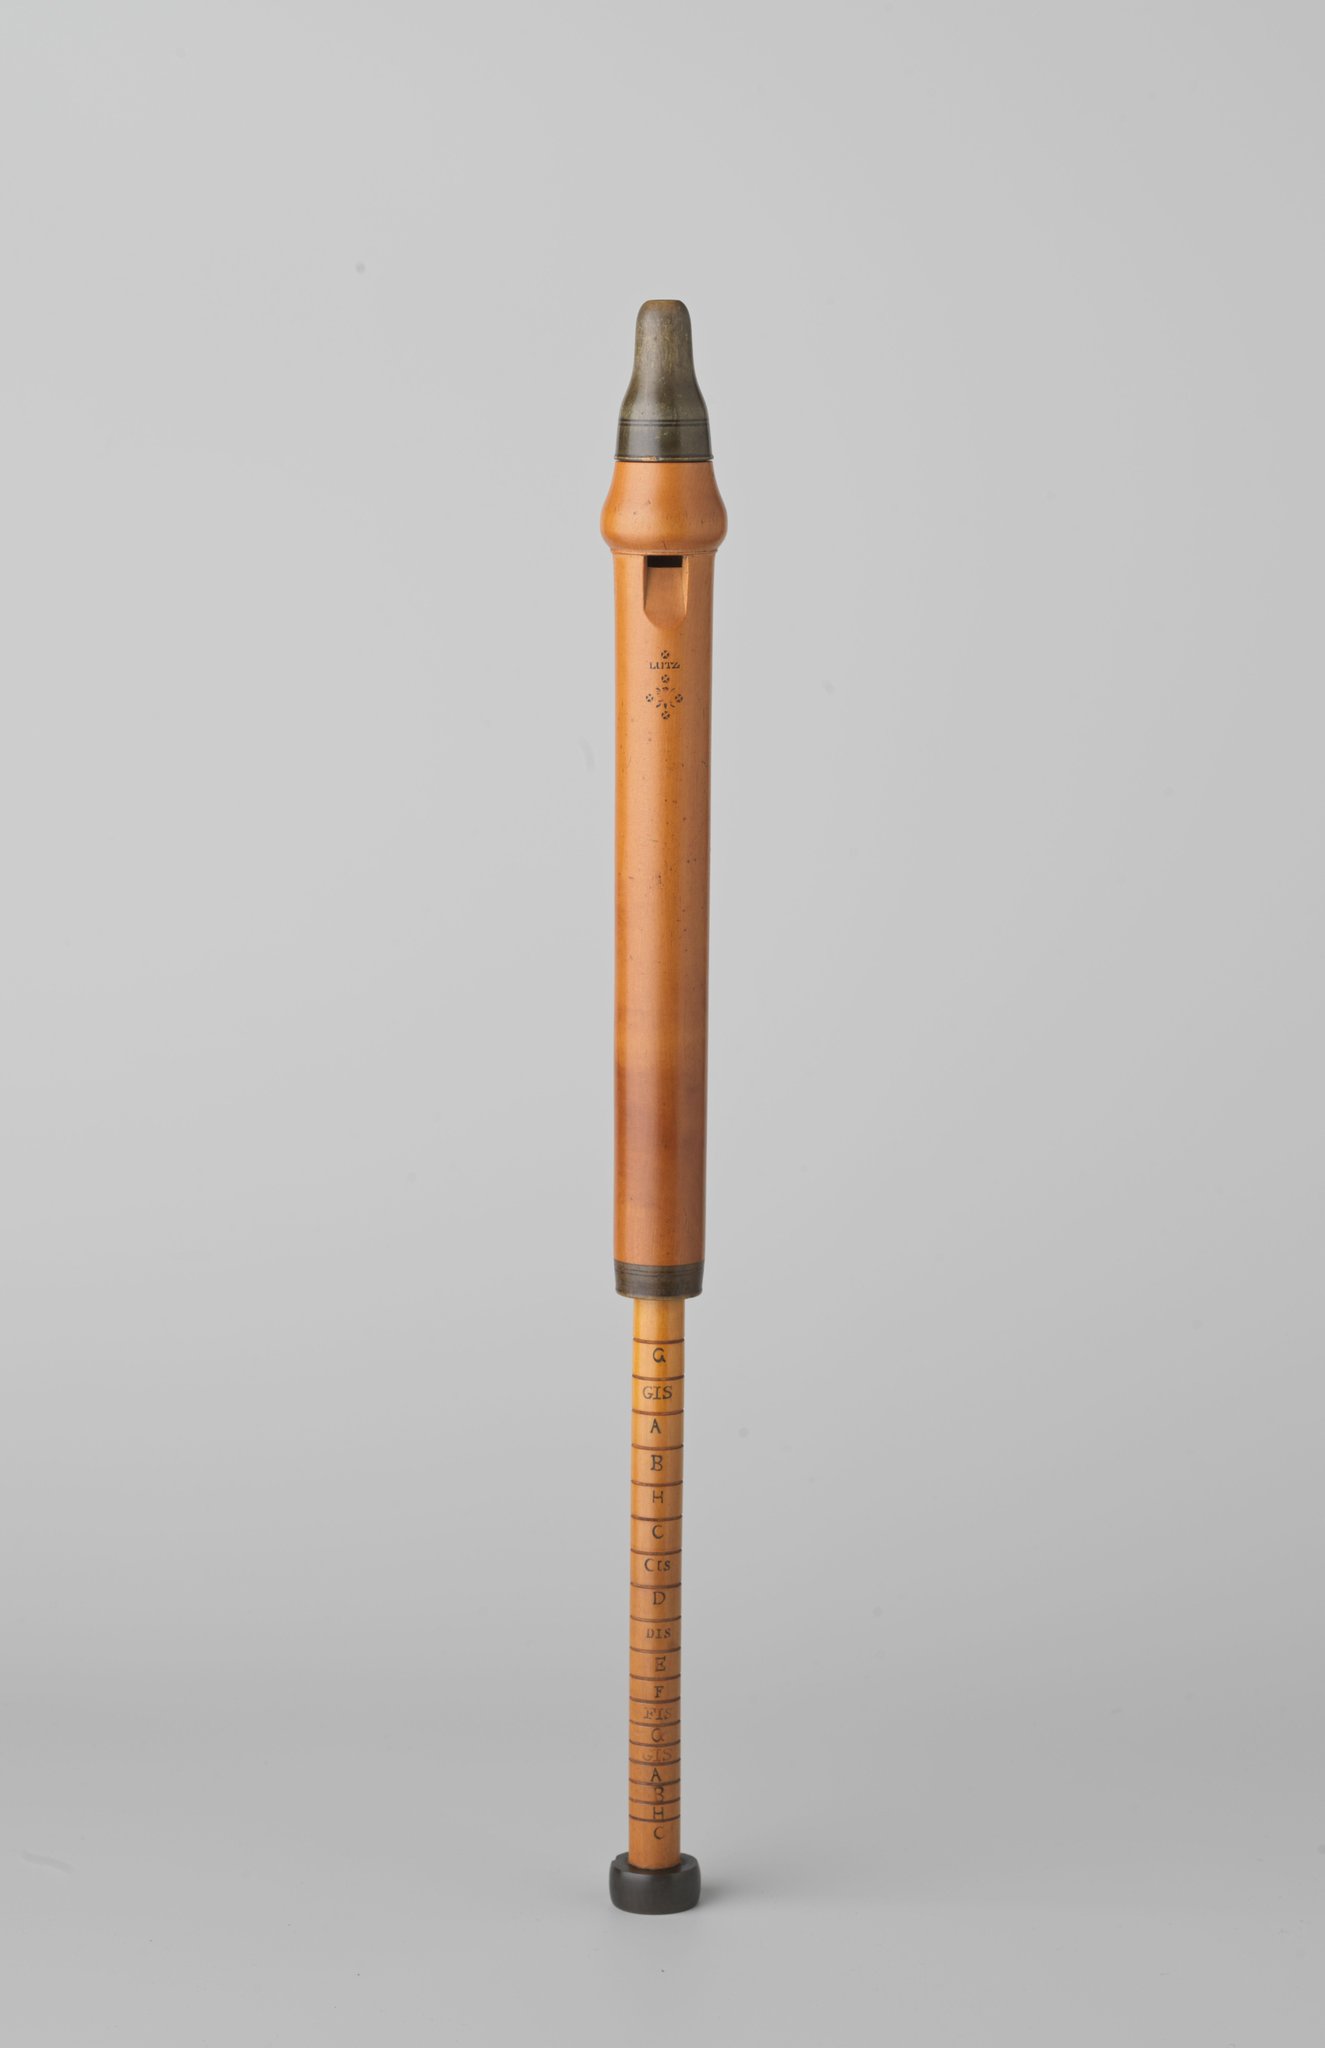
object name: schuiffluit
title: Sliding tuning flute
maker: bartholome lutz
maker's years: 1803-1871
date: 1860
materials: wood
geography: appenzell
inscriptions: stamp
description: Stemfluit gemaakt van kersenhout. Uitgangspunt van de stemming: a-440 Hz. Stempel: × / LUTZ / × / × [engel] × / ×